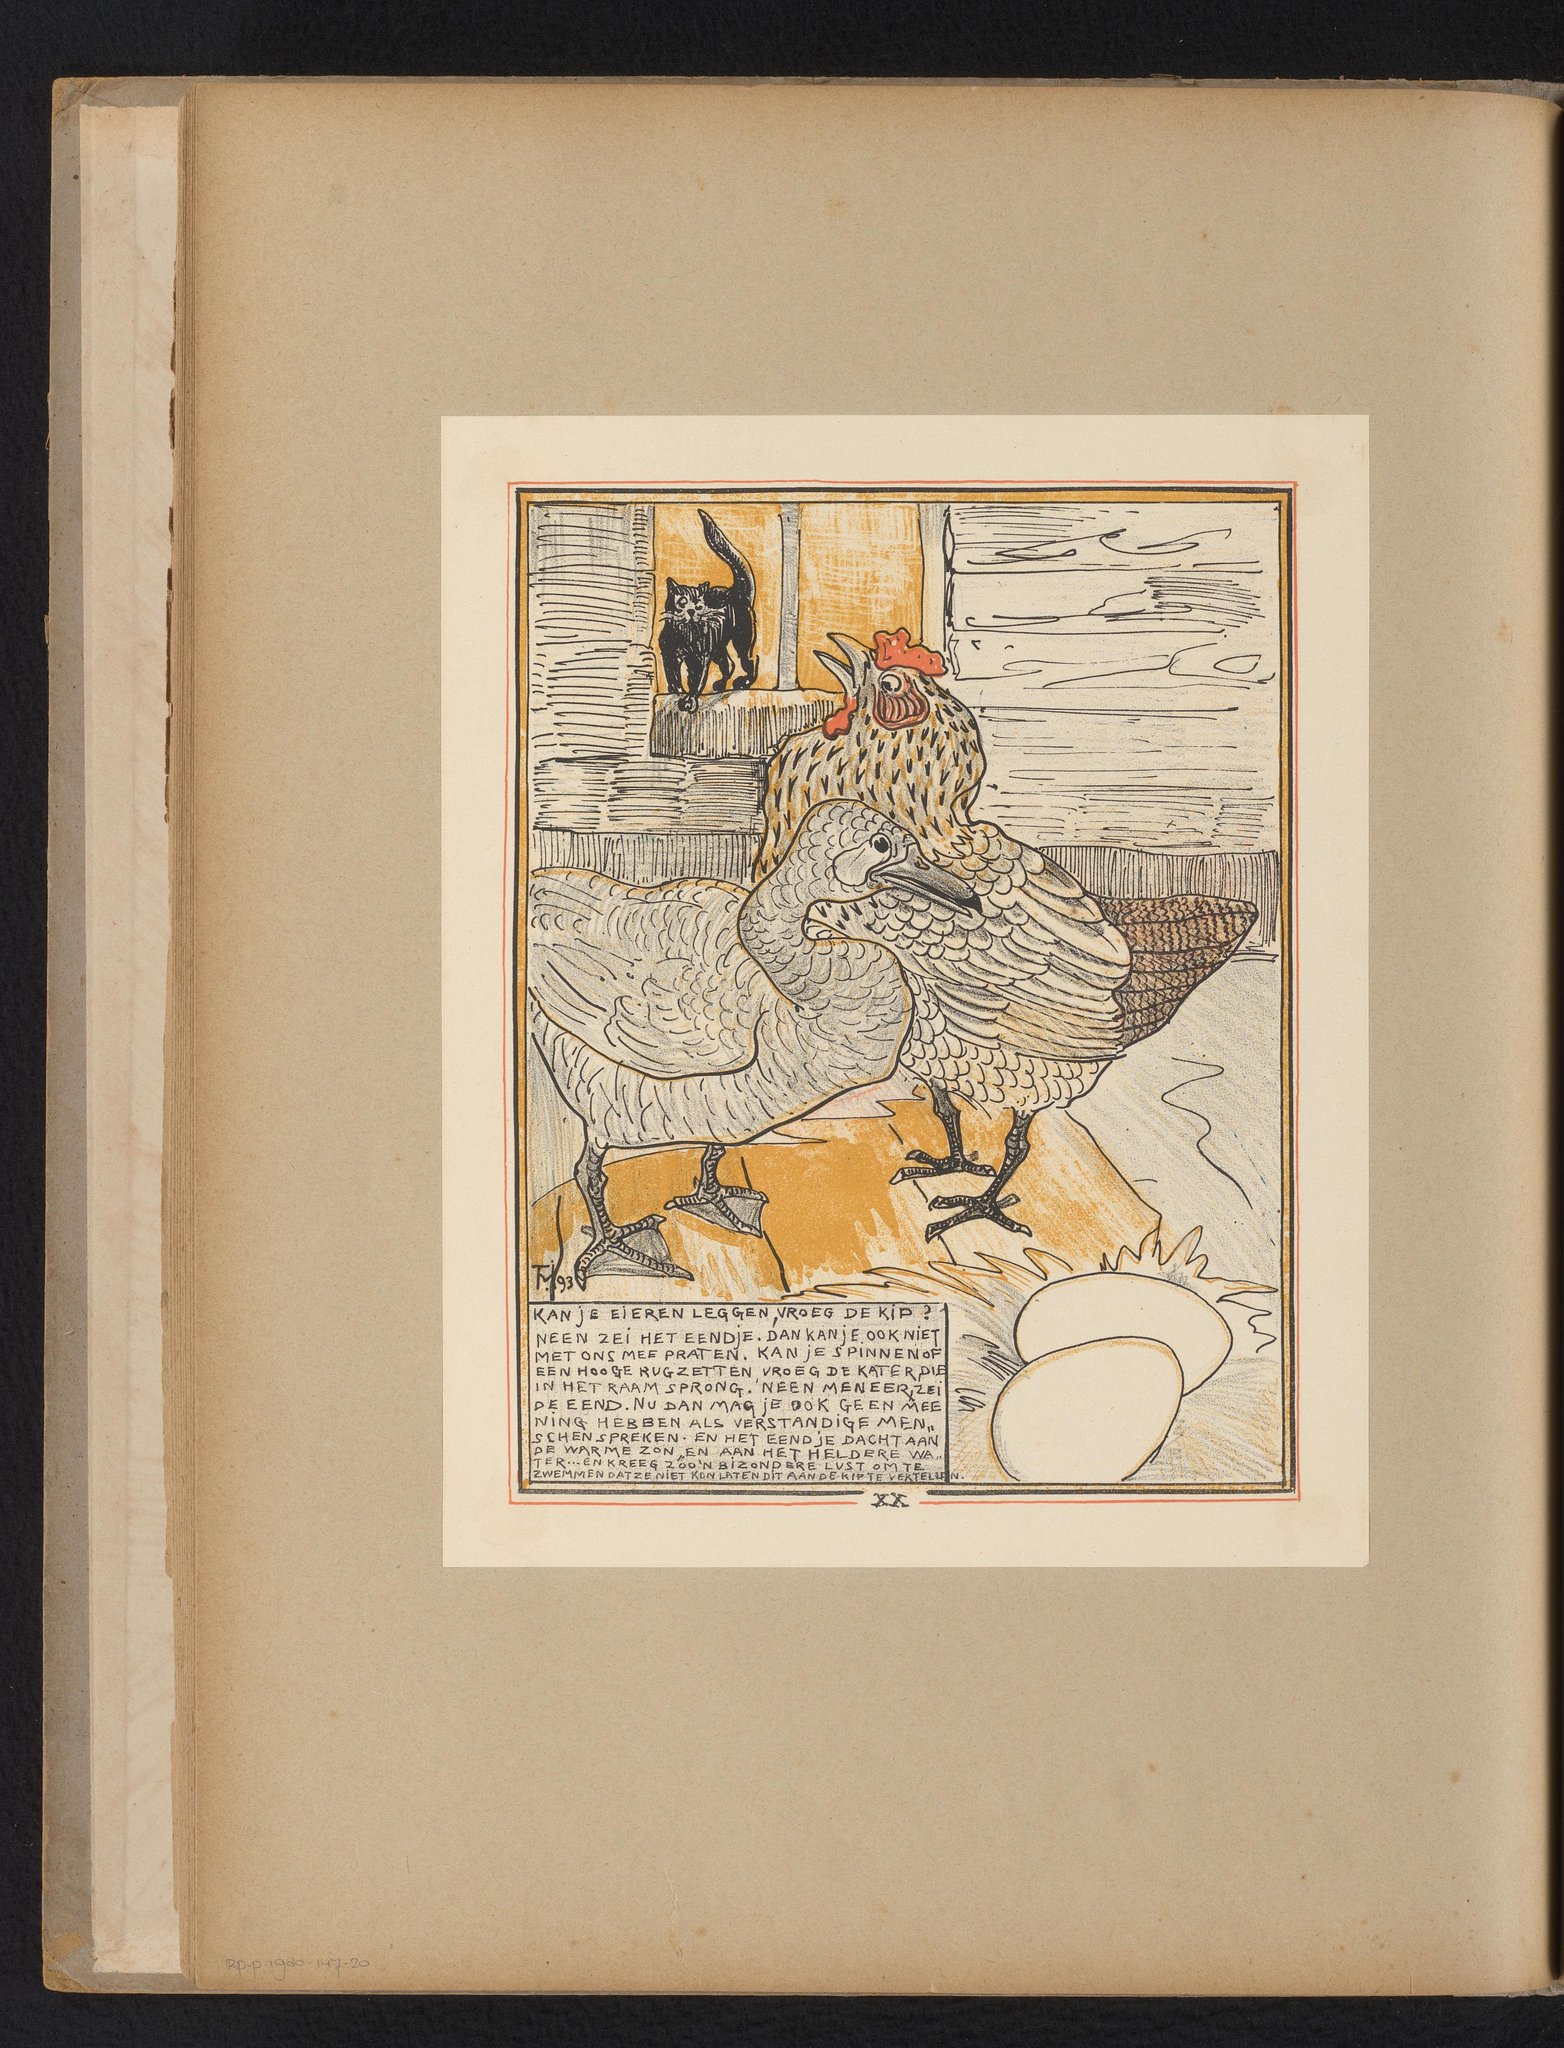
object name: print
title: Kat en kip met het zwanenjong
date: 1893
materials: paper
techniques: lithograph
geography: the hague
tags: cat, fowl (cock, hen, chicken, etc.), water-birds: duck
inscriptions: date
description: Deze prent maakt deel uit van een album.